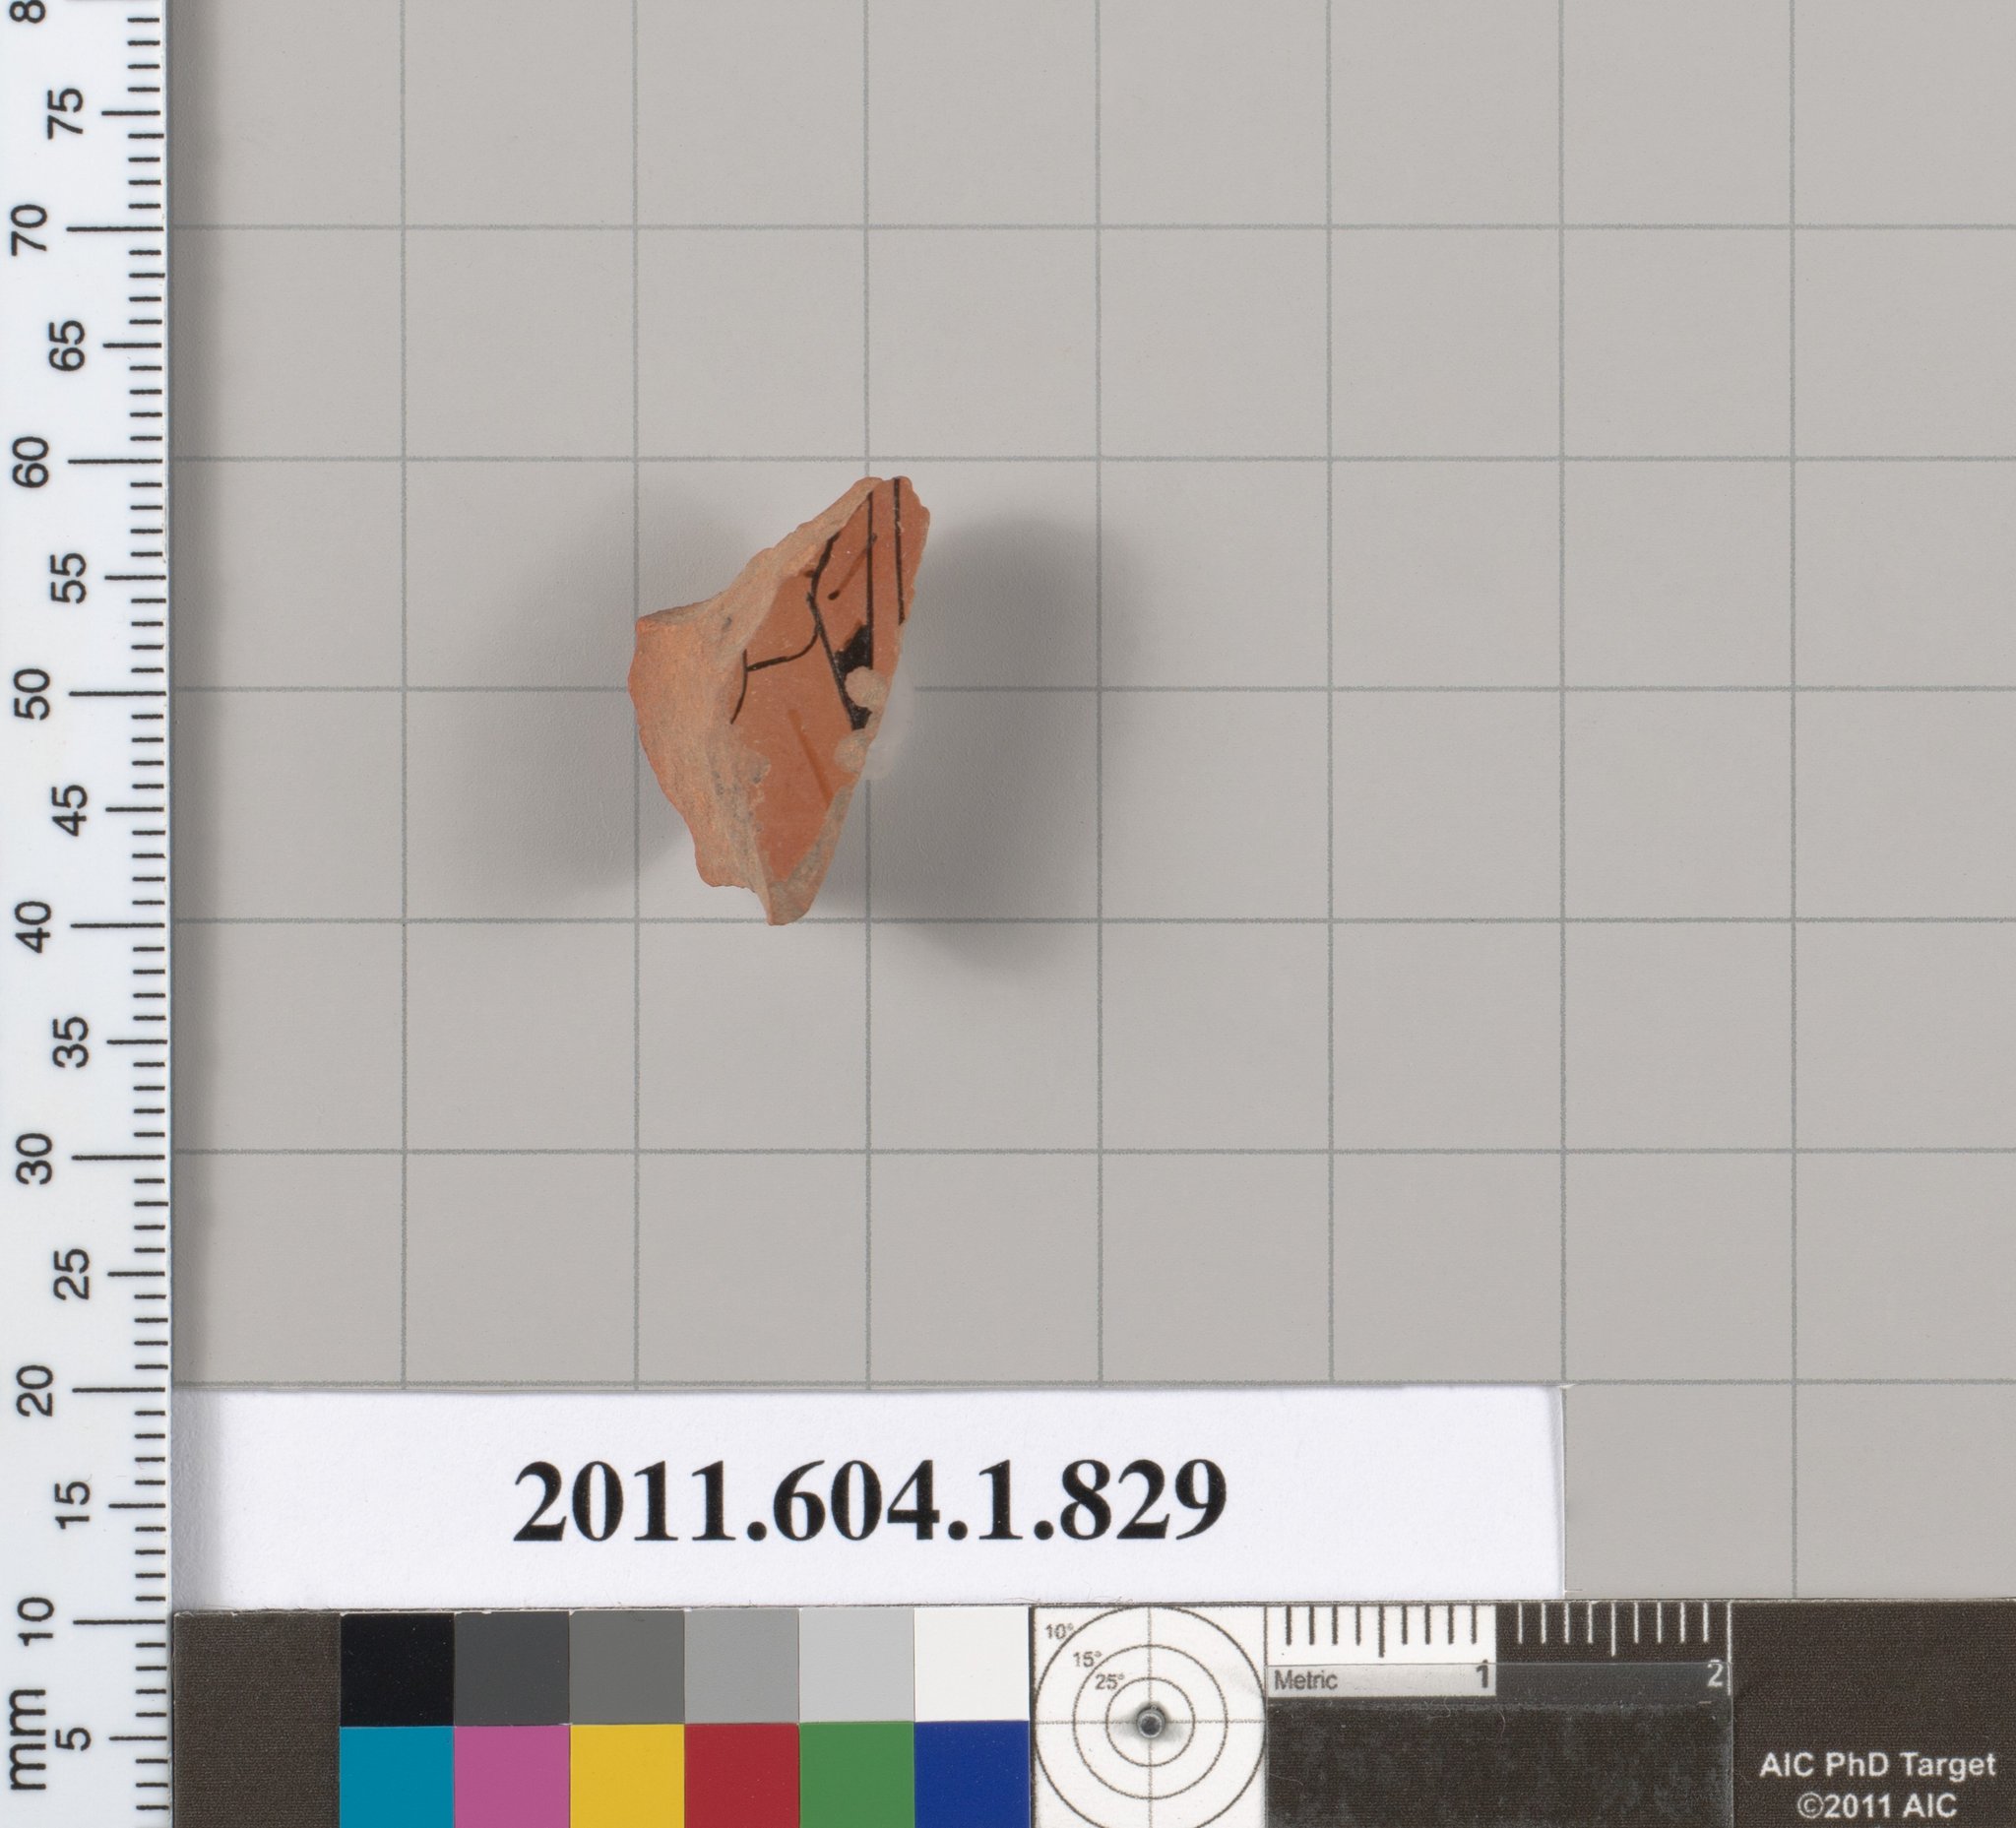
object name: kylix fragment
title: Terracotta fragment of a kylix (drinking cup)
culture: greek, attic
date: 475-451 BCE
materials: terracotta